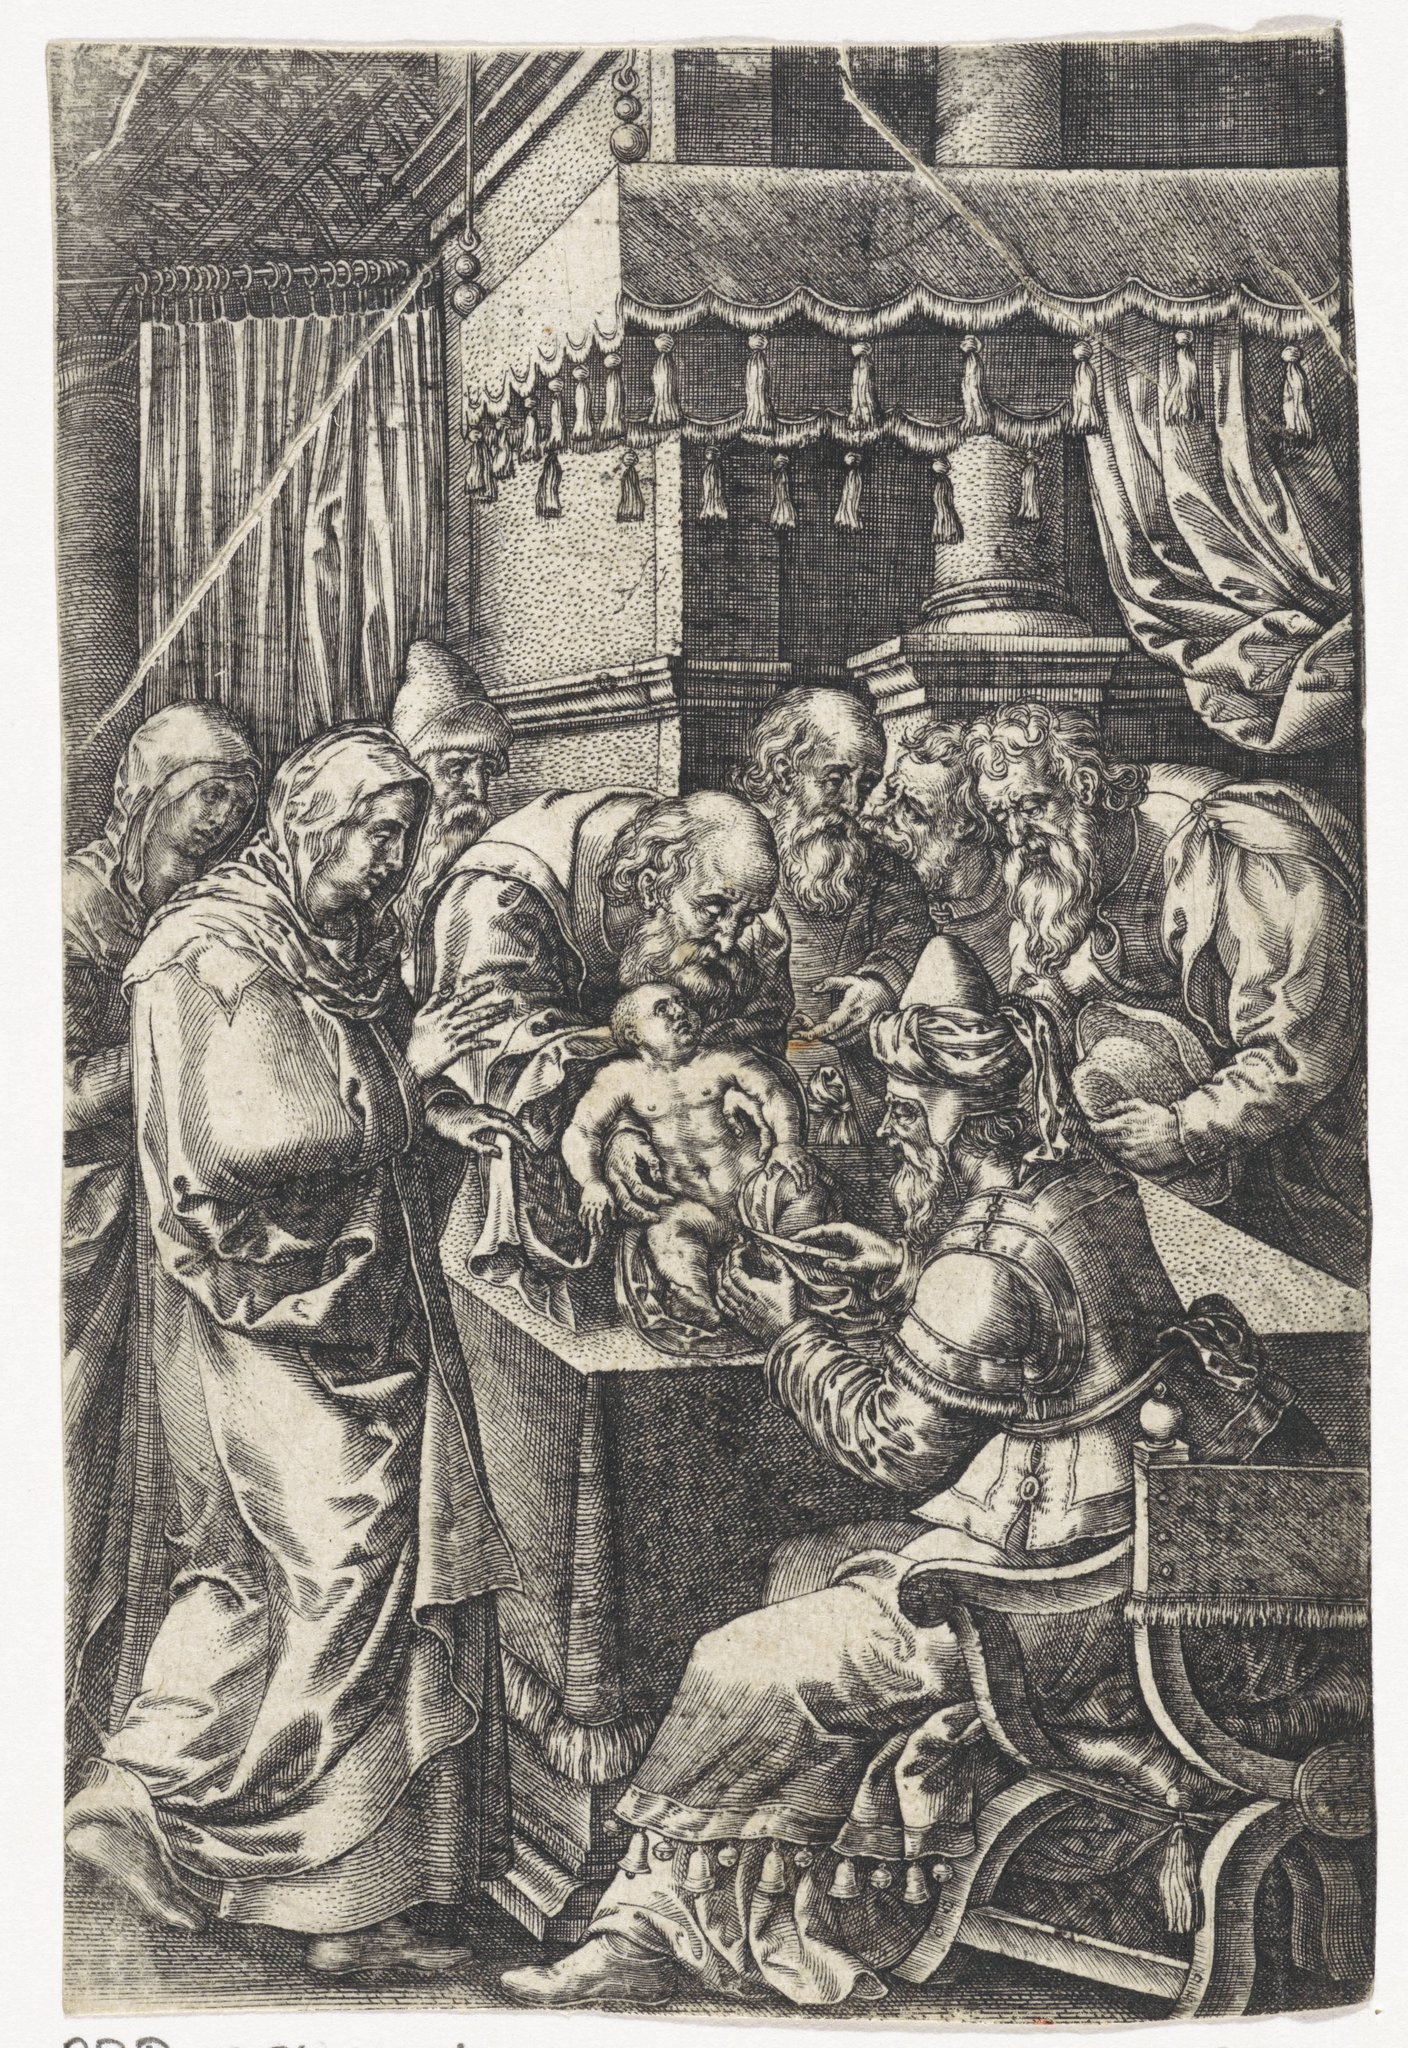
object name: print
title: Besnijdenis van Christus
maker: johannes wierix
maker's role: draughtsman, print maker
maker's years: 1549-1618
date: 1573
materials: paper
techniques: engraving, letterpress printing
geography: antwerp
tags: circumcision of the christ-child by the priest in the temple (luke 2:21)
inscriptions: collector's mark: Lugt 2228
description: De hogepriester besnijdt het Christuskind in de tempel. Maria staat naast het altaar. Omstanders kijken toe.